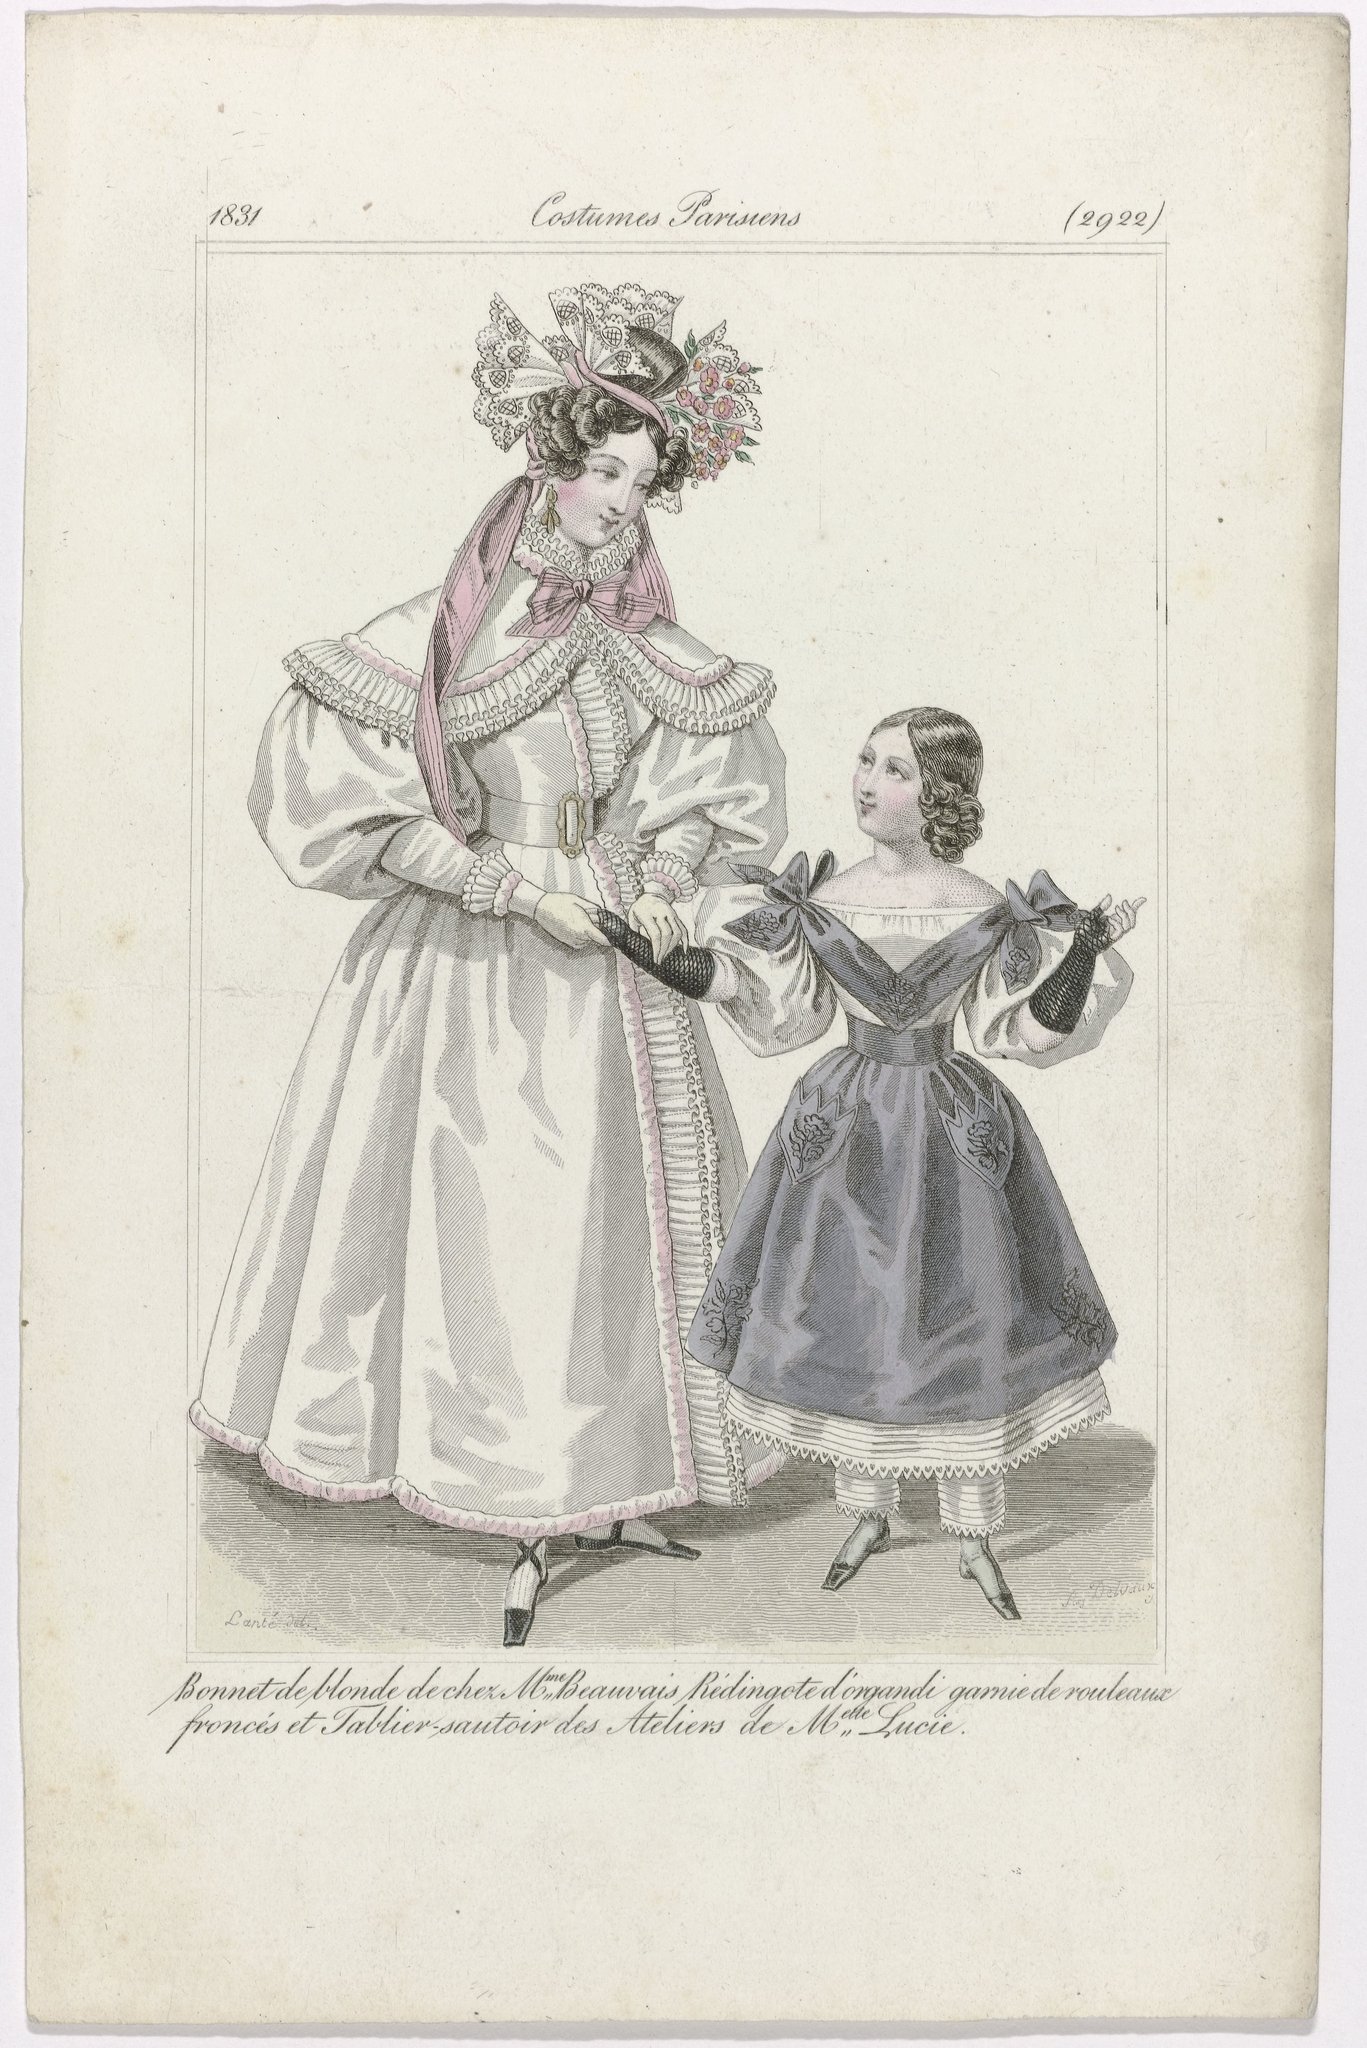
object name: fashion print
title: Journal des Dames et des Modes, Costumes Parisiens, 25 septembre 1831, (2922): Bonnet de blond (...)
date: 1831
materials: paper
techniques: engraving, hand coloring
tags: ear-rings (+ women's clothes), head-gear: cap (+ lace used for clothes), apron (+ girls' clothes), dress, gown: redingote (+ women's clothes), underclothes for the lower part of the body: bloomers (+ girls' clothes), gloves, mittens (mitaines) (+ girls' clothes), head-gear: cap (+ women's clothes), fashion plates, shoes, sandals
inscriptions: title: ‘Costumes Parisiens.’, caption: ‘Bonnet de blonde chez M"me Beauvais Rédingote d'organdi garnie de rouleaux froncés et Tablier-sautoir des Ateliers de M"elle Lucie.’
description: Vrouw met op het hoofd een muts van Blonde (kloskant), door Beauvais. Zij draagt een redingote van organdie, afgezet met een 'rouleaux froncés', van het atelier van Lucie. Verdere accessoires: oorbel in het rechteroor, ceintuur met gesp, platte schoenen met gekruiste banden en vierkante neuzen (cothurnes). Meisje gekleed in een japon met 'tablier-sautoir' (schort), van het atelier van Lucie. Onderrok en bloomers. Accessoires: mitaines, laarzen met vierkante neuzen. De prent maakt deel uit van het modetijdschrift Journal des Dames et des Modes, Parijs, 1797-1839.